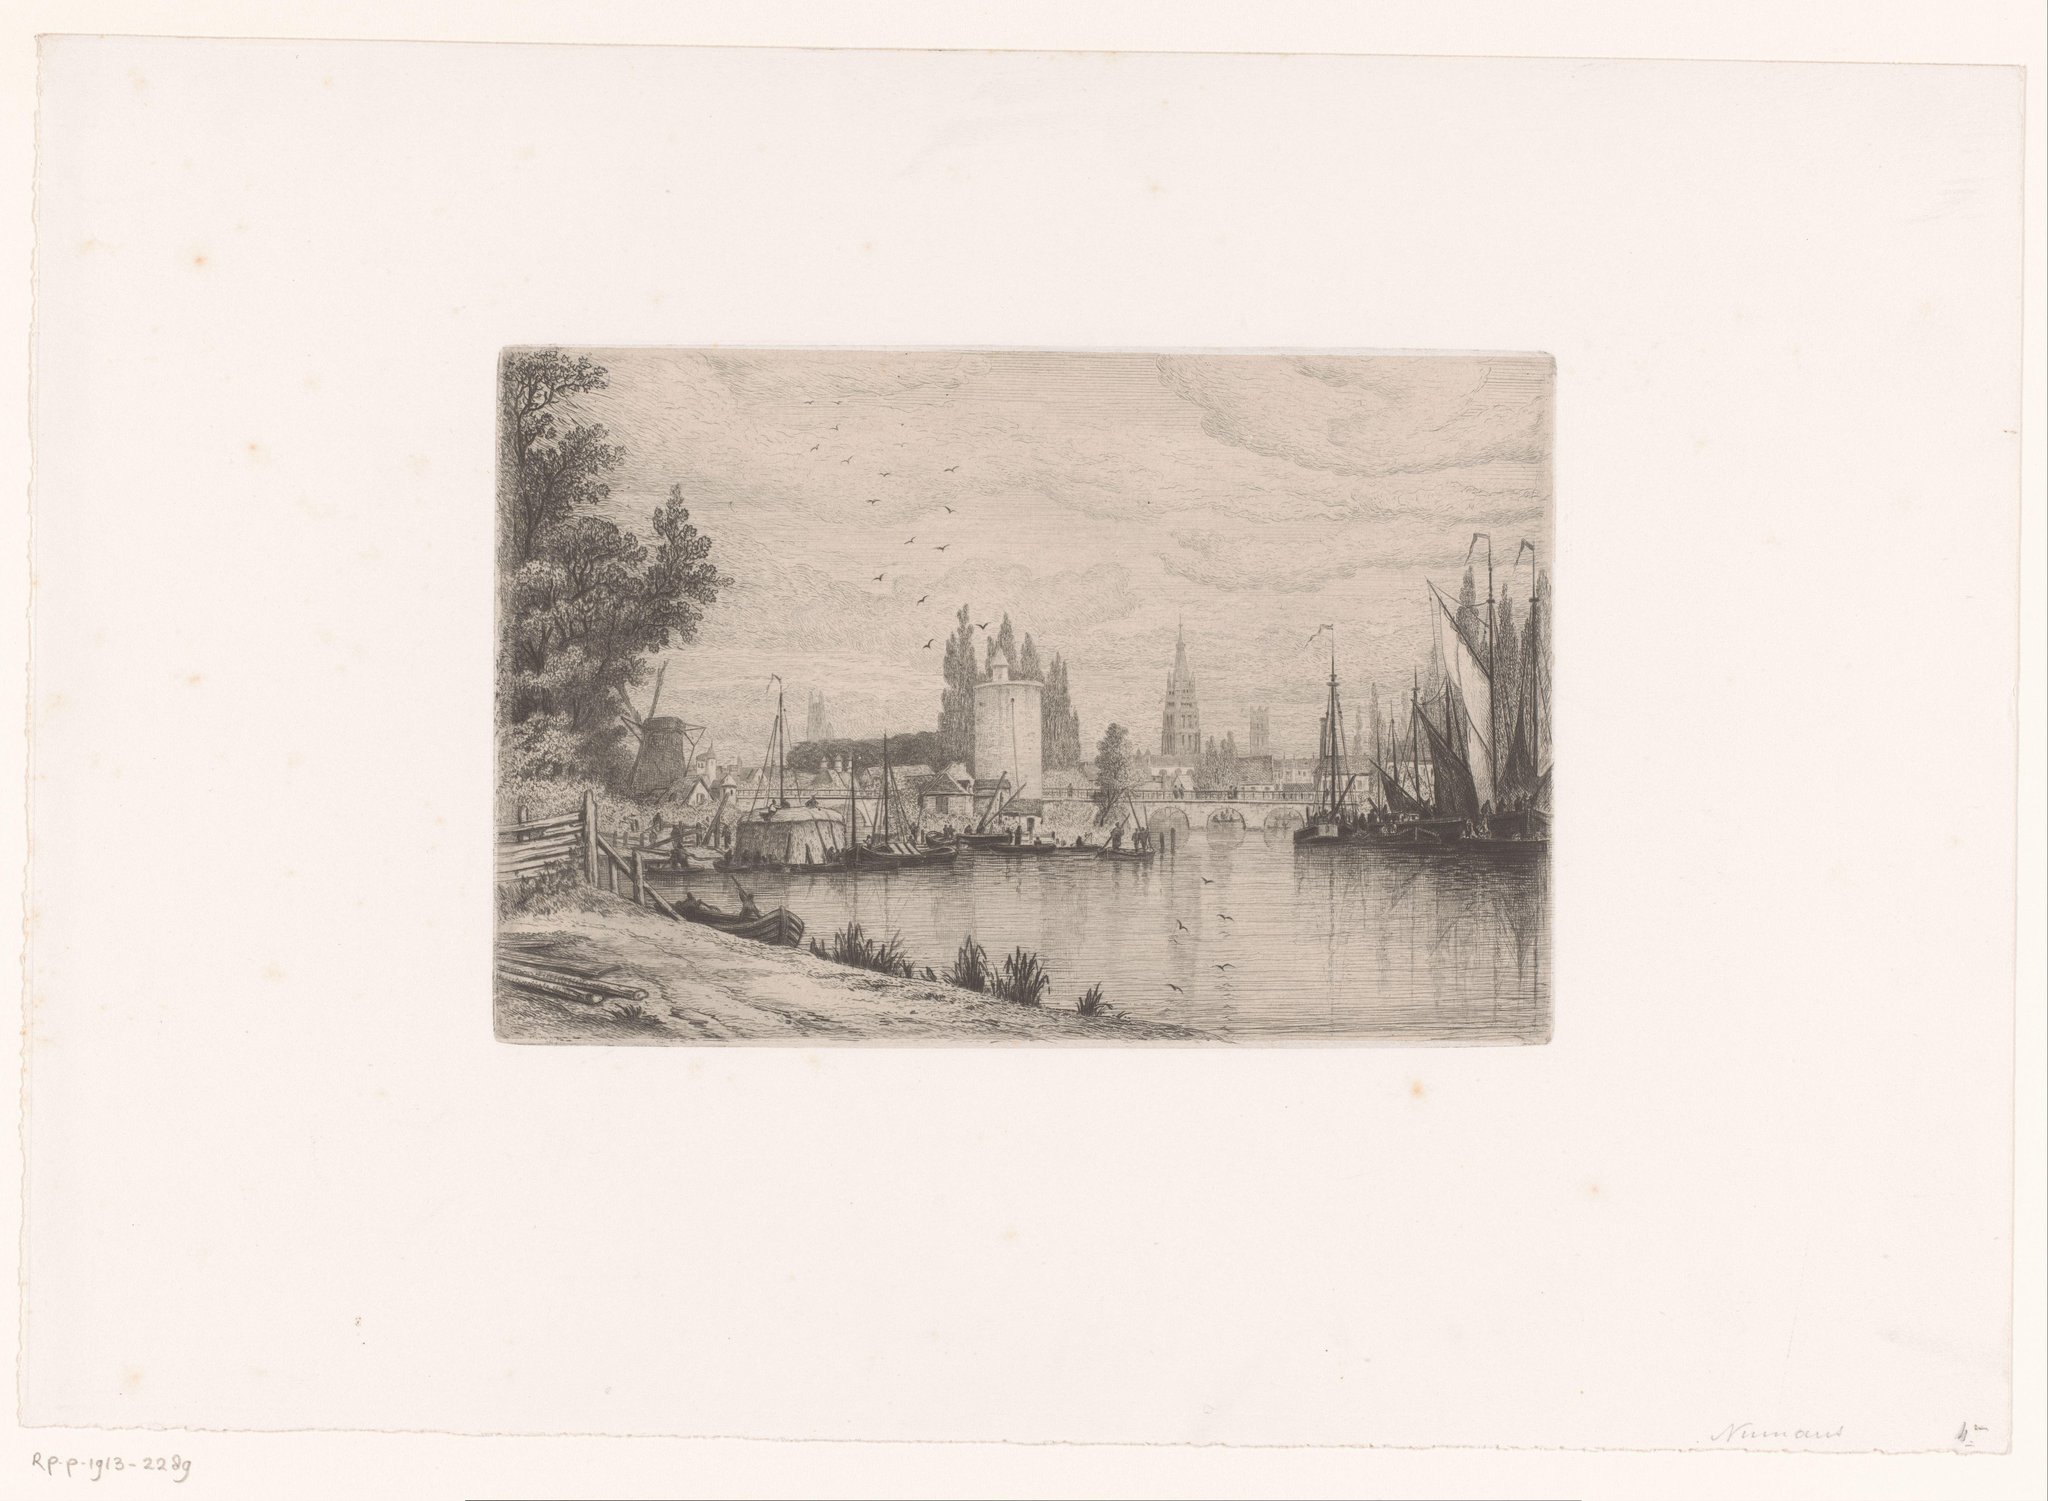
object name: print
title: Gezicht op een stad, mogelijk Brugge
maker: auguste numans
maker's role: print maker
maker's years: 1823-1883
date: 1833-1879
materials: paper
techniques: etching, intaglio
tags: harbour, city-view, and landscape with man-made constructions, bridge, bruges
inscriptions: collector's mark: Lugt 2228